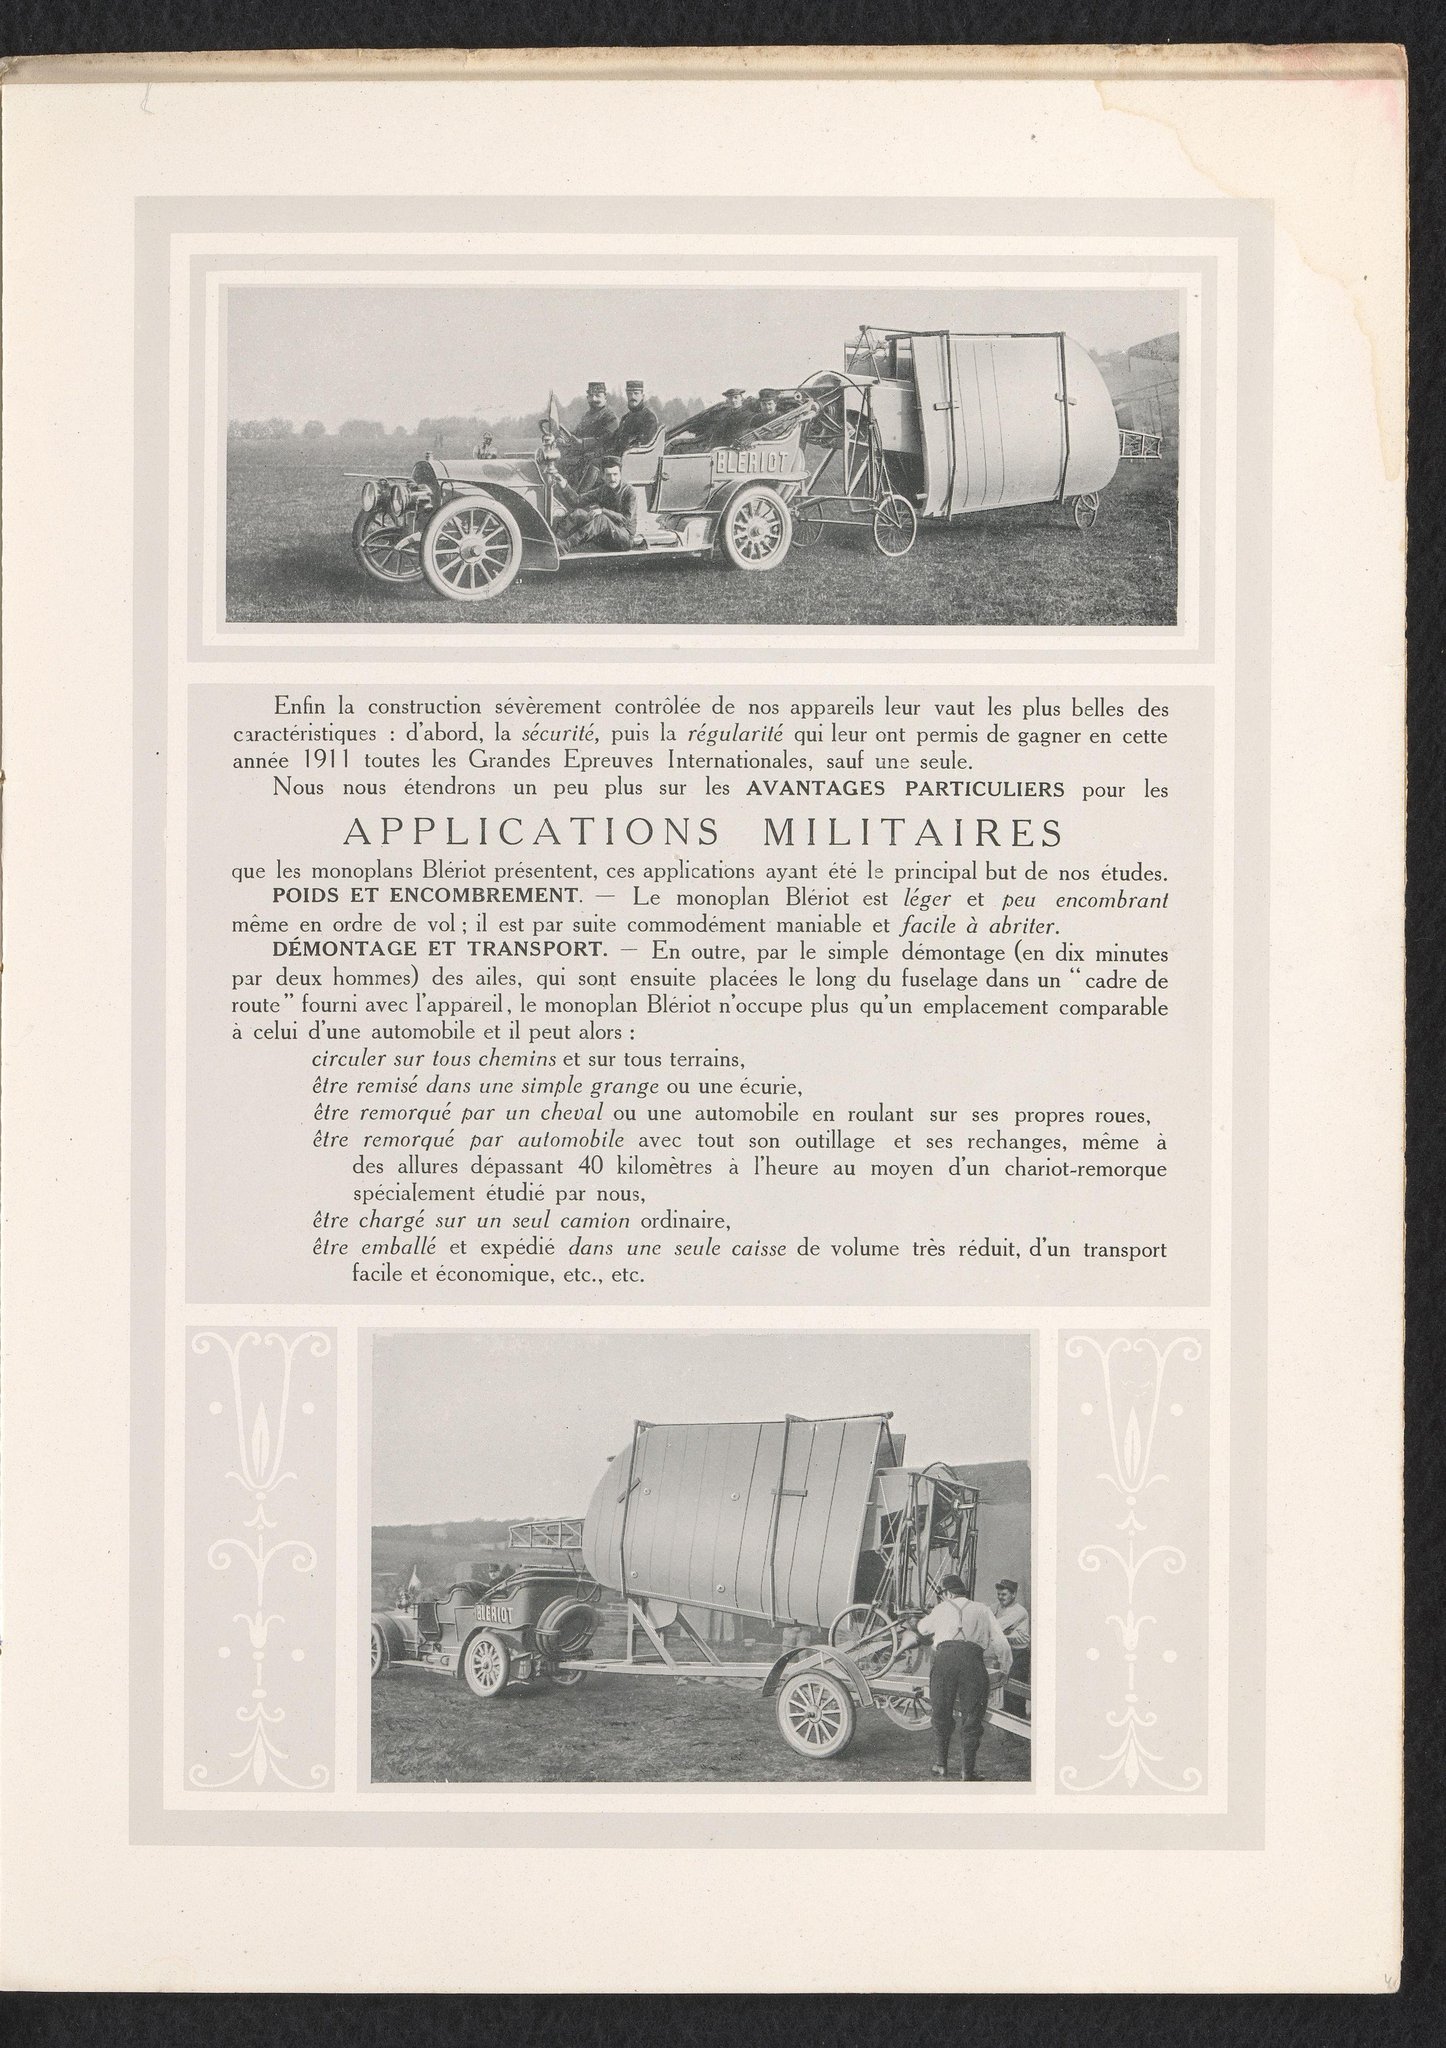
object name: photomechanical print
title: Twee beelden van bemanning bij auto met vliegtuig in aanhanger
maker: Anonymous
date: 1907-1912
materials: paper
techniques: letterpress printing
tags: aircraft, aeroplane, flight crew, automobile